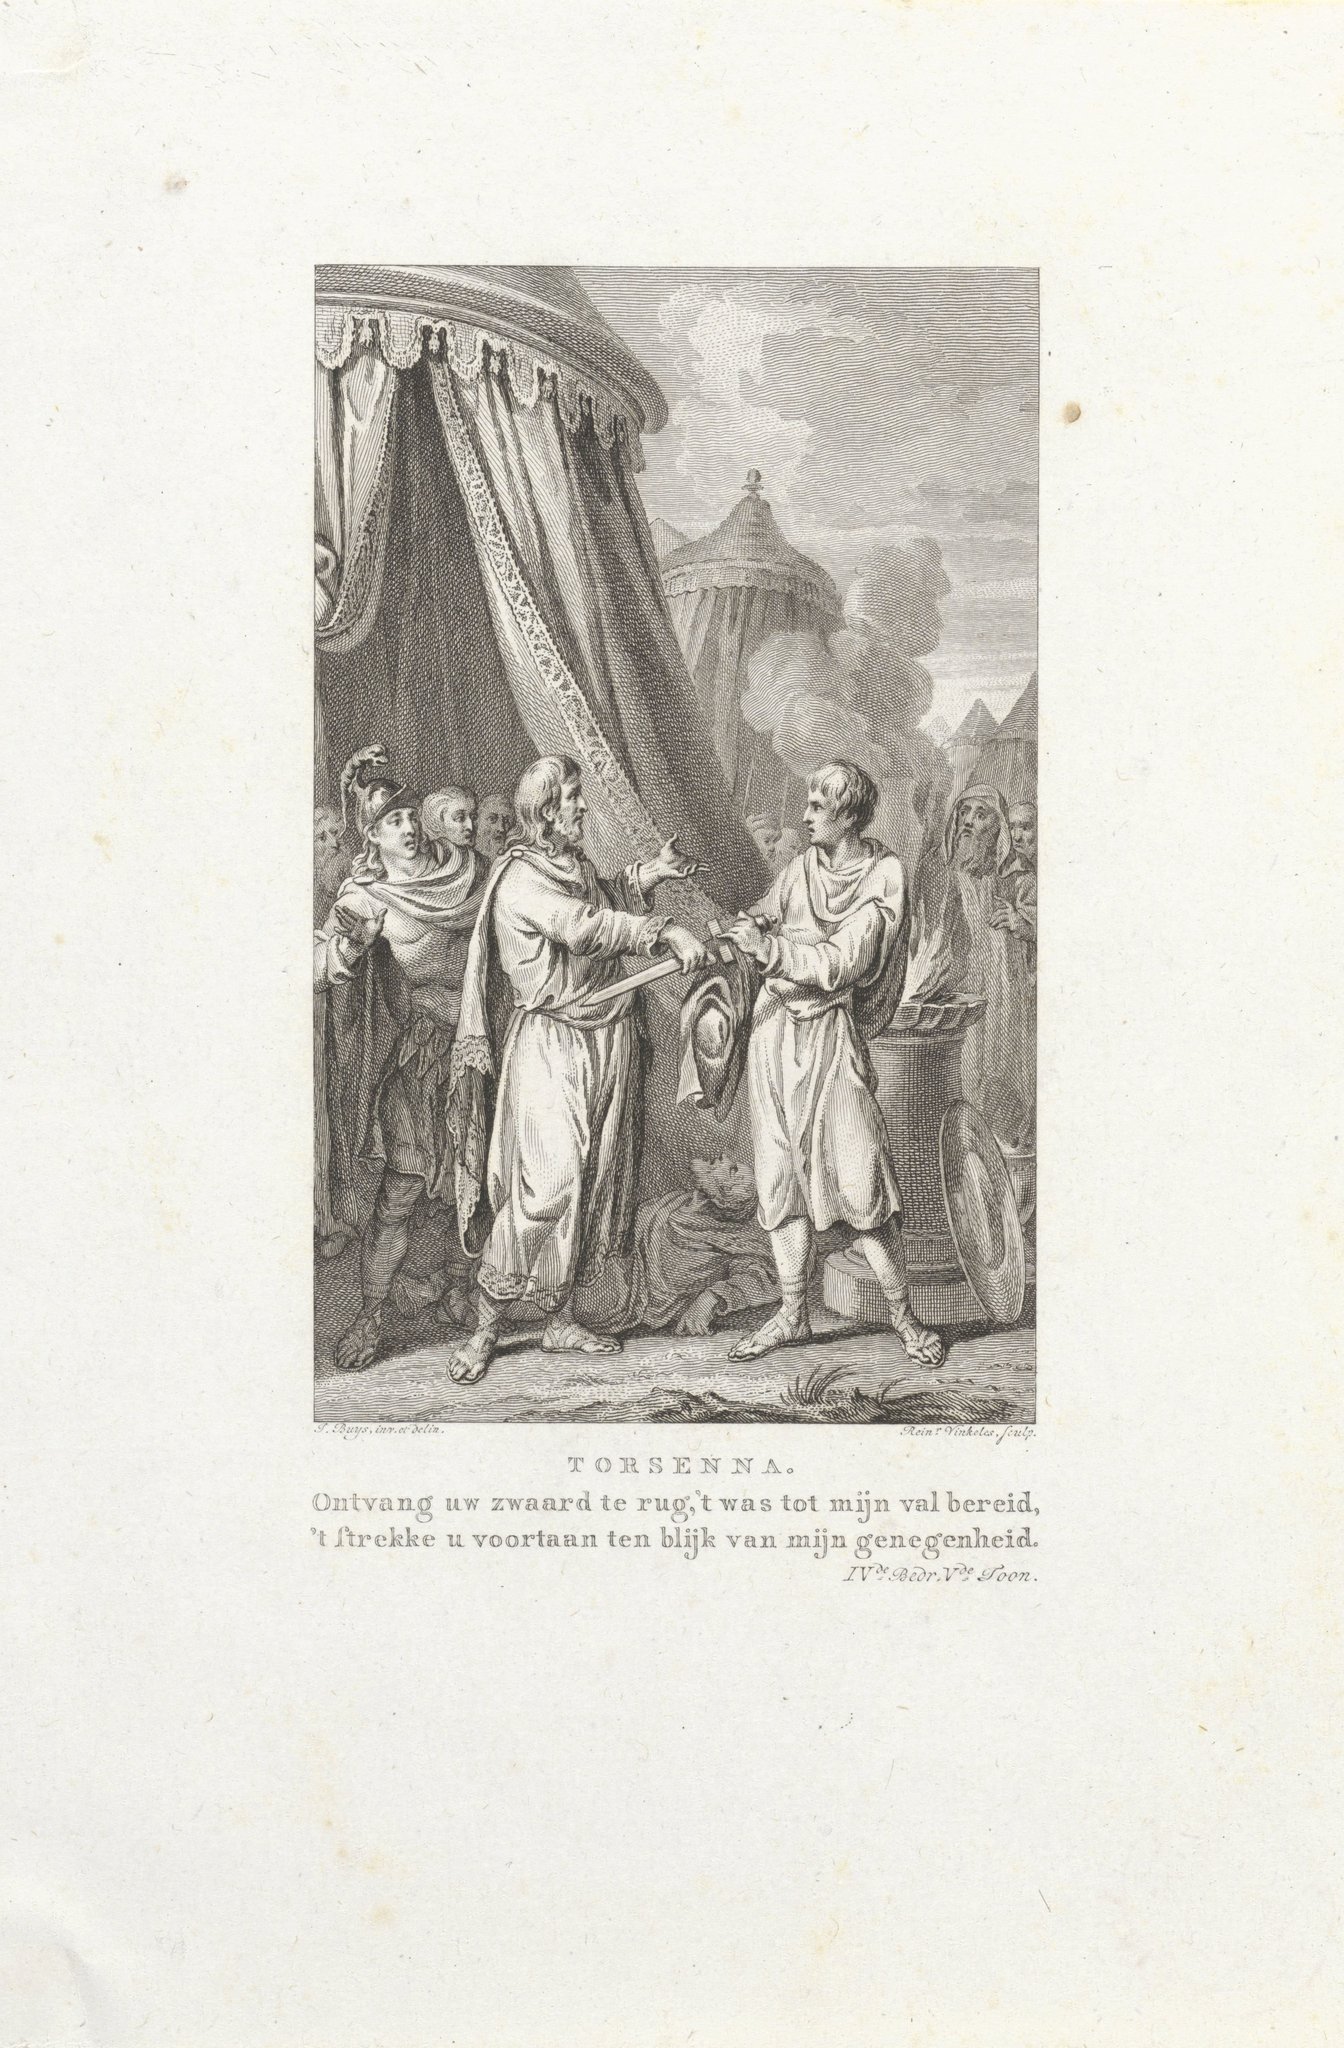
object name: print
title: Torsenna geeft een zwaard terug aan een man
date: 1795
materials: paper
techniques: engraving, etching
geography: amsterdam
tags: hacking and thrusting weapons: sword, tent-camp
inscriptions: collector's mark: Lugt 240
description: In een legerkamp geeft Torsenna het zwaard terug aan een man. Illustratie voor het toneelstuk 'C. Mucius Cordus, of De verlossing van Rome' van Rhijnvis Feith.